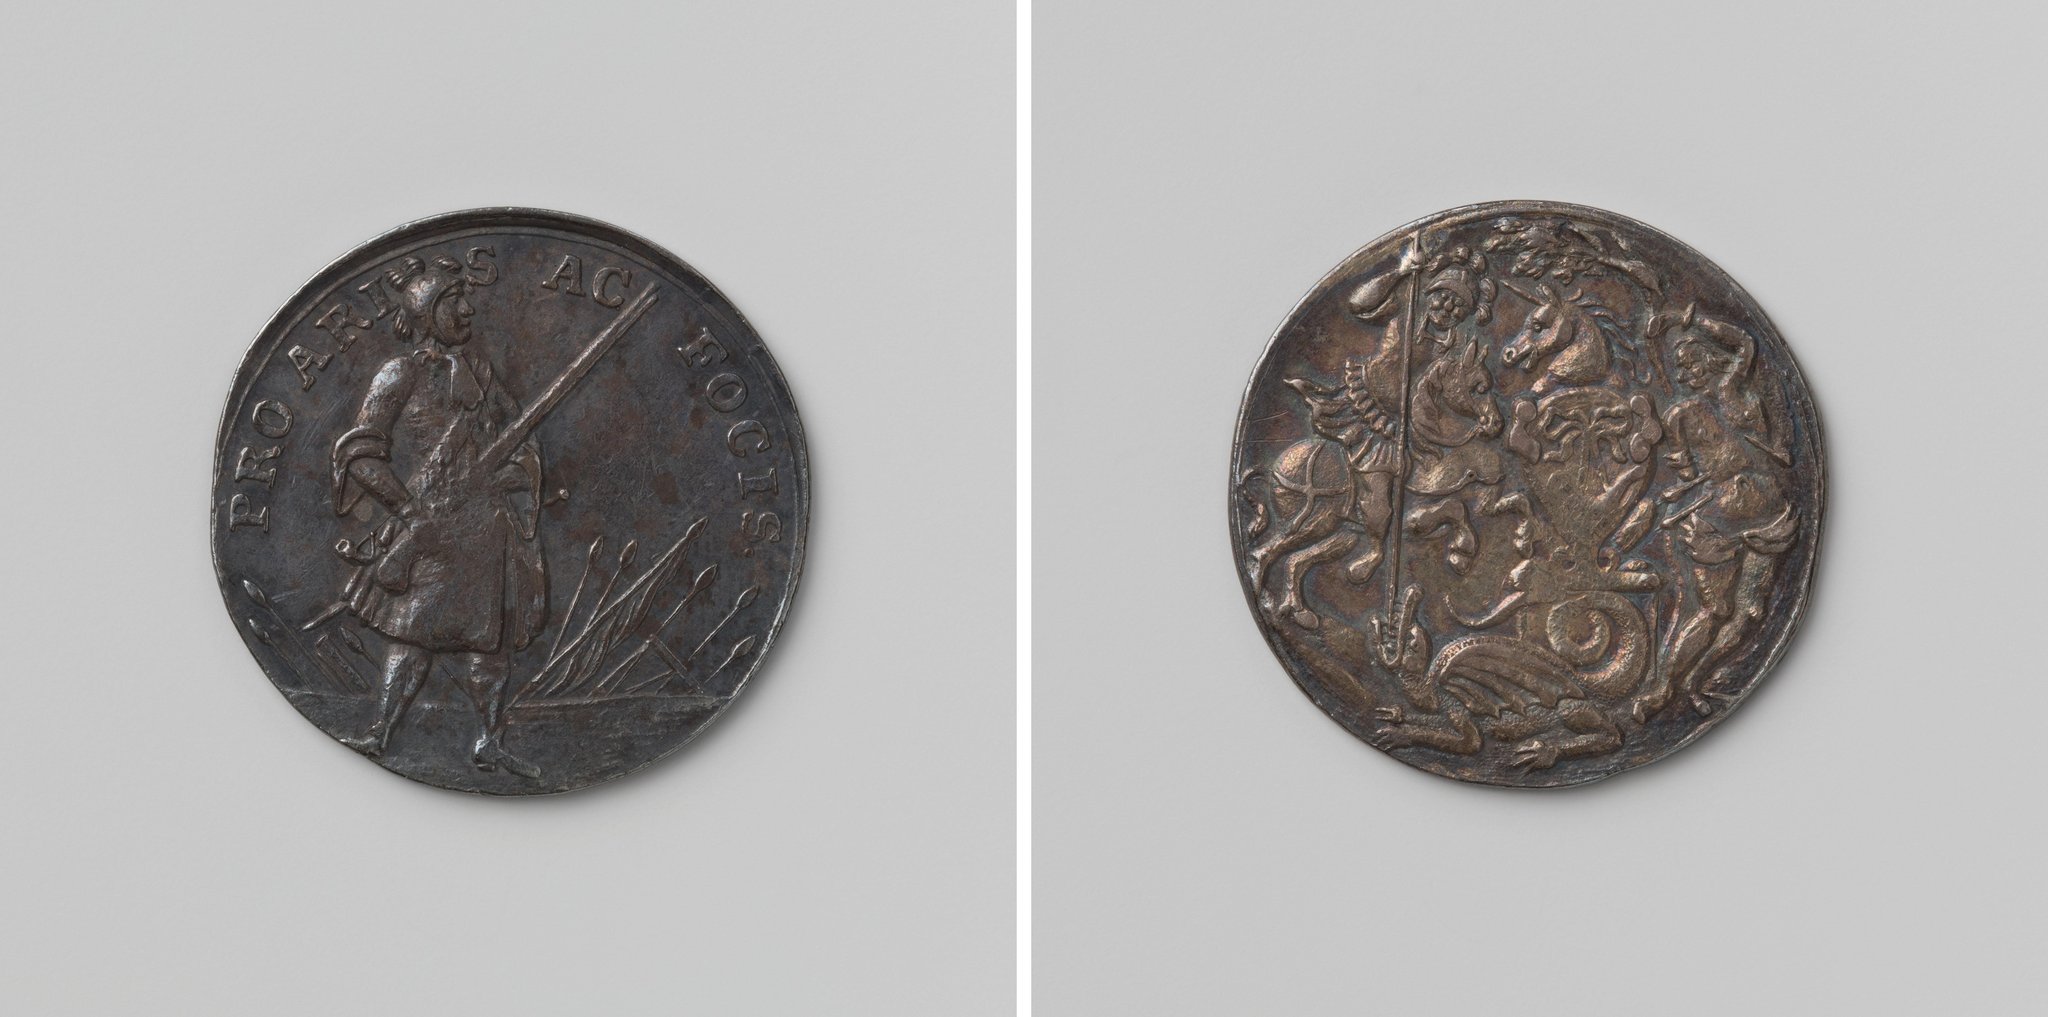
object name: marksman medal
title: Schutterij van Hoorn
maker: jacob t lam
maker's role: die cutter, silversmith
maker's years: 1664-1720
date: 1696-1697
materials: silver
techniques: striking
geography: hoorn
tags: hoorn (north holland)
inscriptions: inscription: ‘PRO ARIS AC FOCIS’